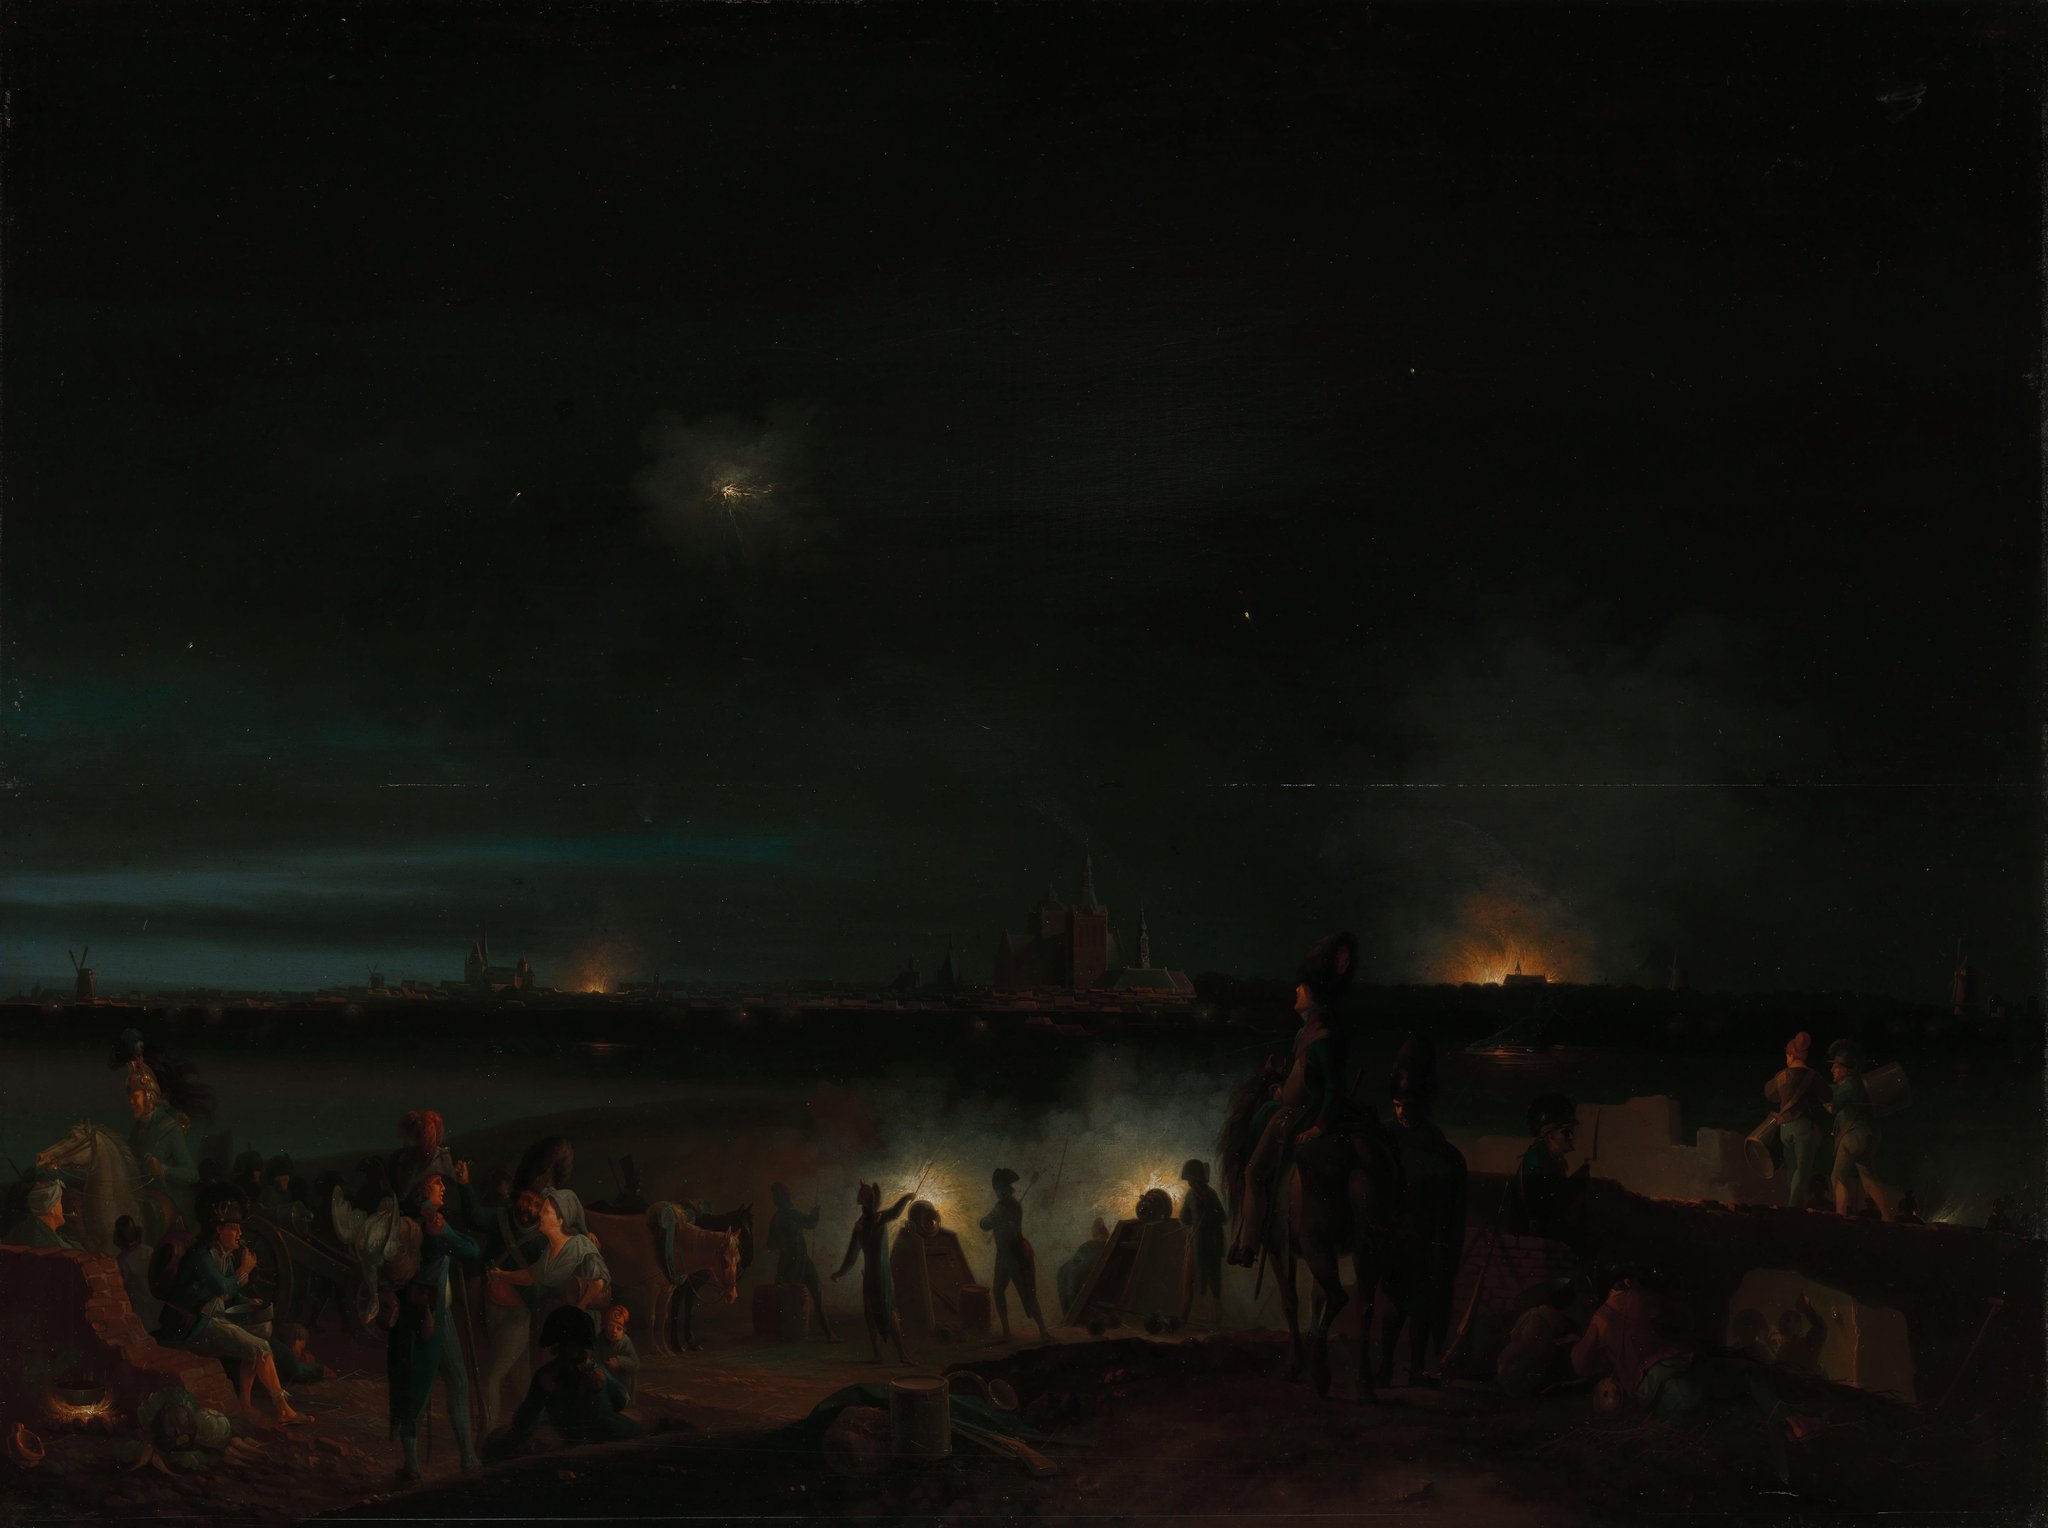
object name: painting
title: The Bombardment of 's-Hertogenbosch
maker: josephus augustus knip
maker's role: draughtsman, painter, print maker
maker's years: 1777-1847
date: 1800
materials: oil, panel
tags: siege, night, den bosch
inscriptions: signature and date: ‘J.A. Knip 1800’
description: At the request of the Patriots, a French army invaded the Dutch Republic in September 1794. After a siege lasting more than two weeks, ’s-Hertogenbosch was captured on 10 October. The city was shelled –even at night –with cannons set up by the French. To keep out the attackers, a large area around the city was flooded.